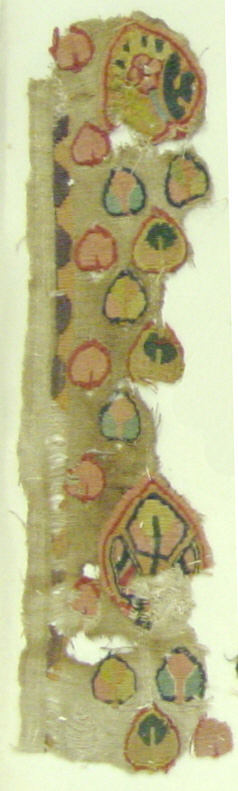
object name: textile fragment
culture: coptic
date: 401-500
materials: linen, wool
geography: egypt